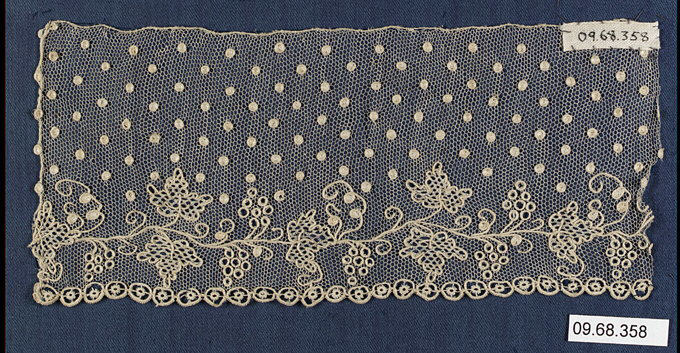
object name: fragment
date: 1801-1900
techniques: lace